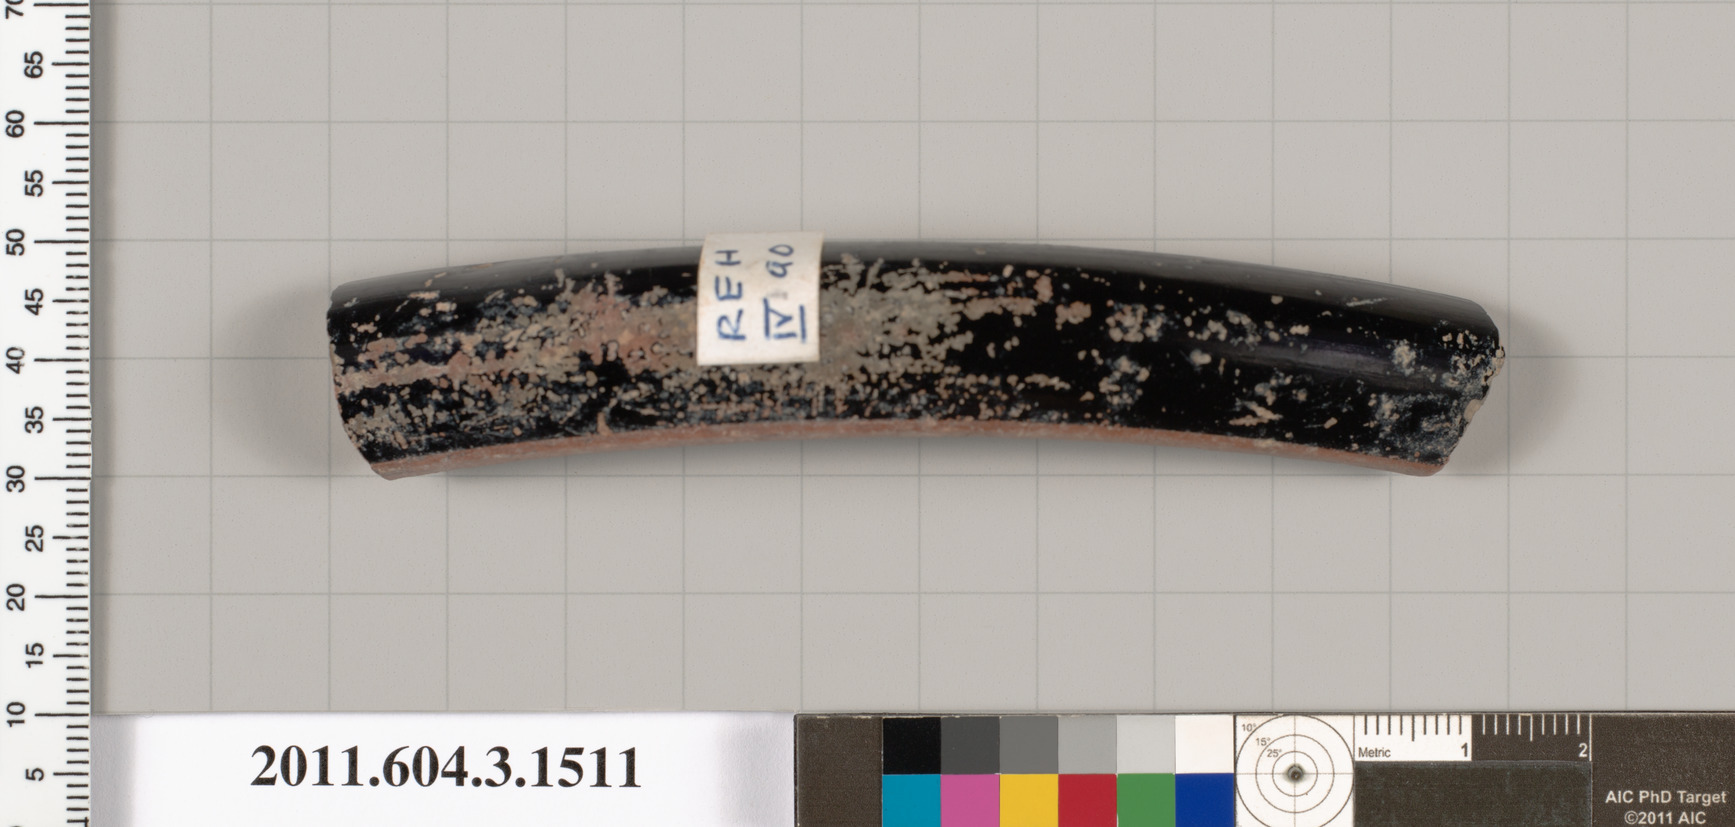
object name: skyphos fragment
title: Terracotta fragment of a skyphos (deep drinking cup)?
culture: greek, attic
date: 600-401 BCE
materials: terracotta